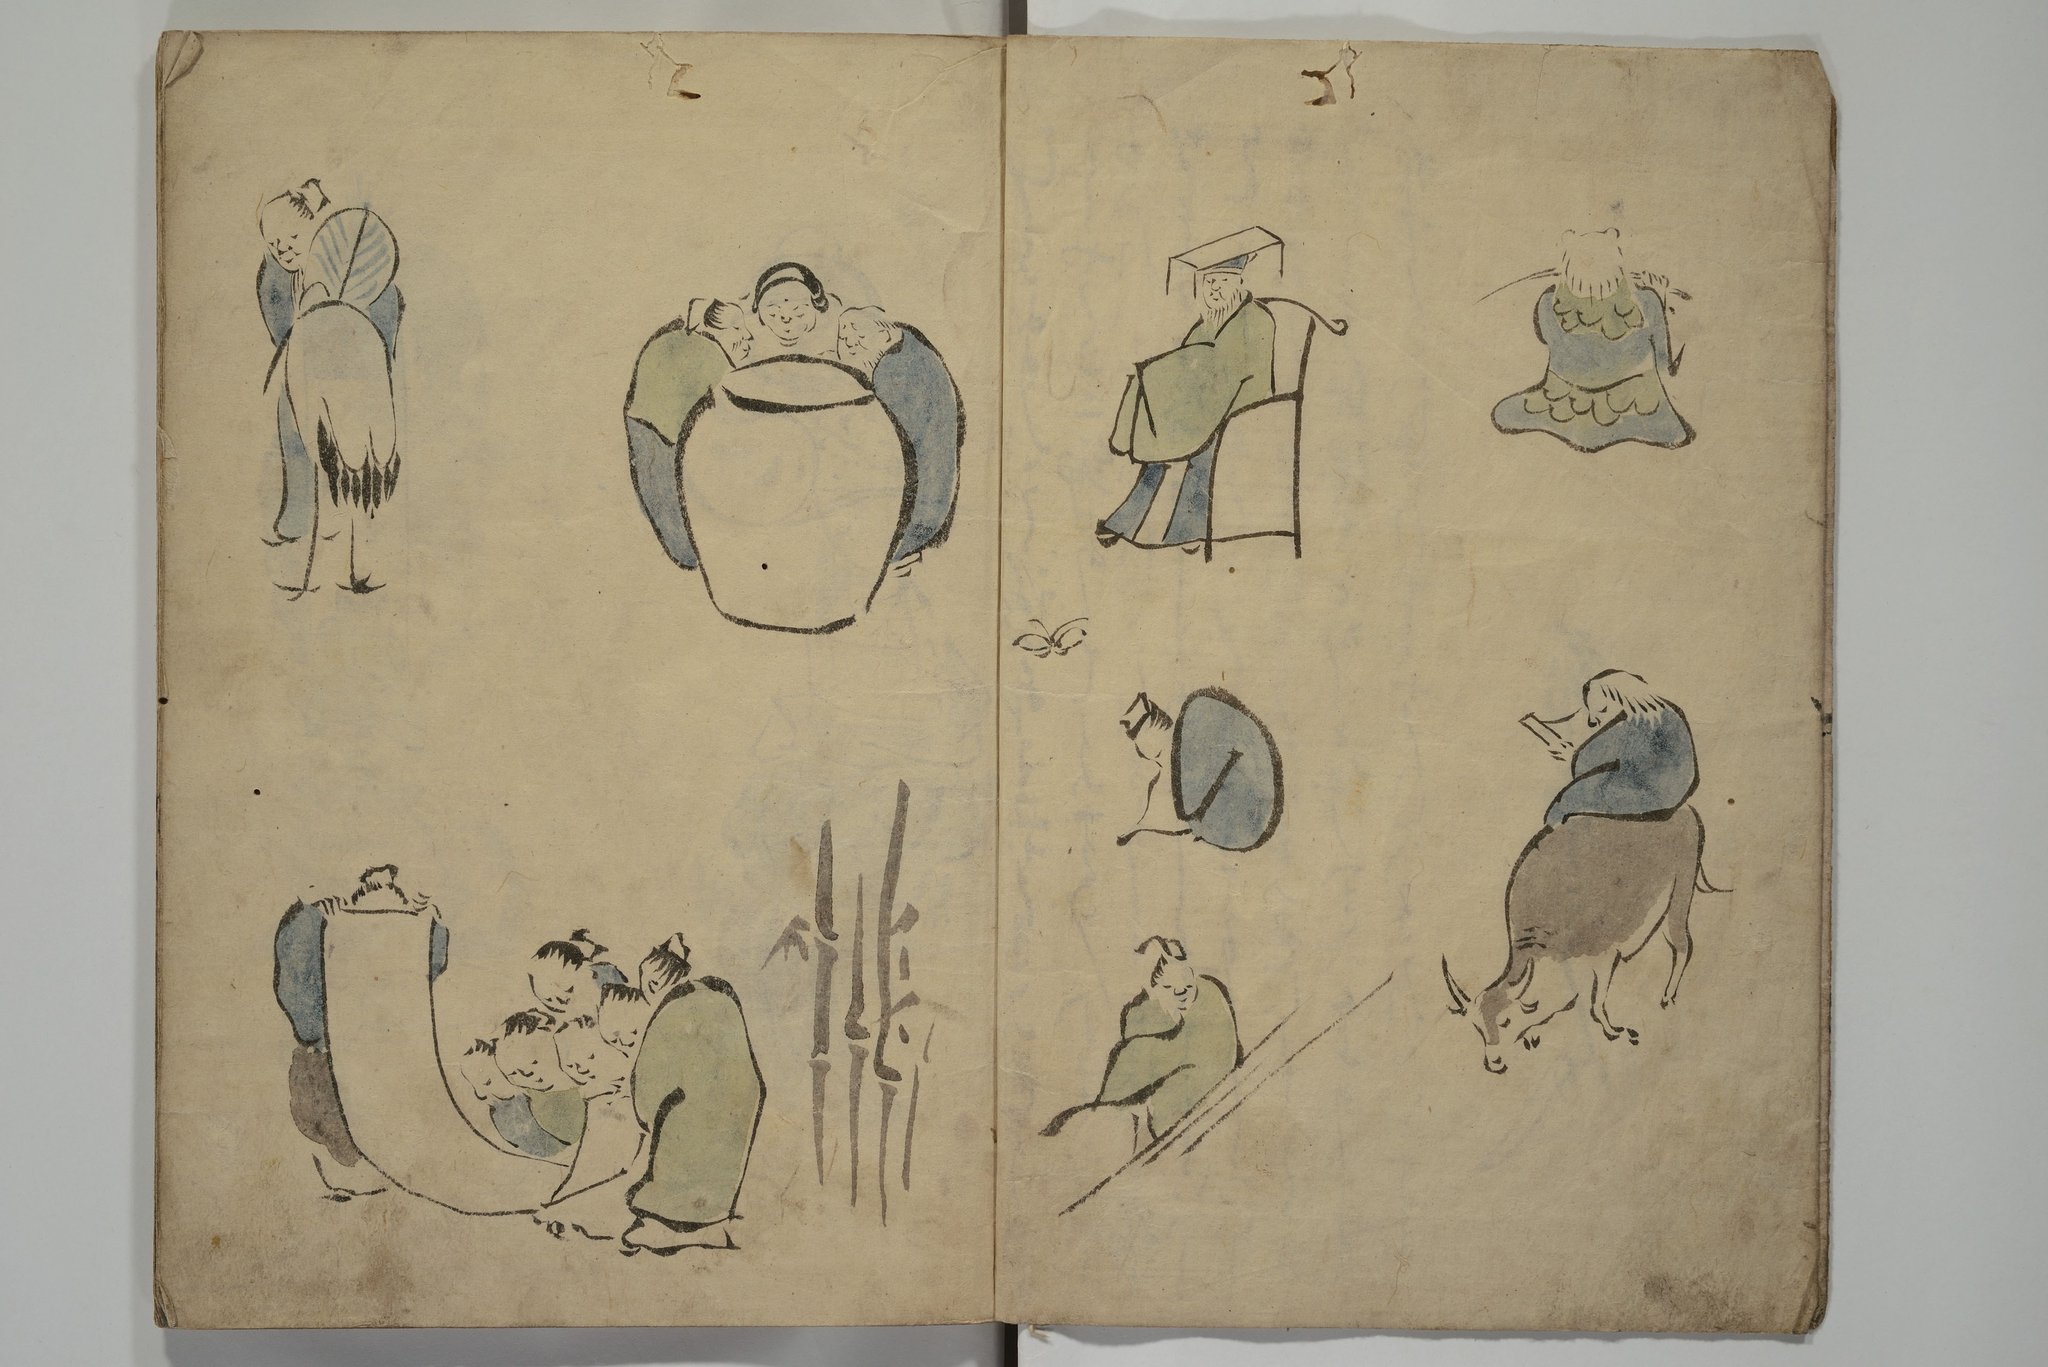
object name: illustrated book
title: How to Draw Figures Simply (Jinbutsu ryakugashiki) 人物略画式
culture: japanese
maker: kuwagata keisai 鍬形蕙斎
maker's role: artist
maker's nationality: japanese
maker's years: 1764-1824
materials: ink, paper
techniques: woodblock print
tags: human figures,animals